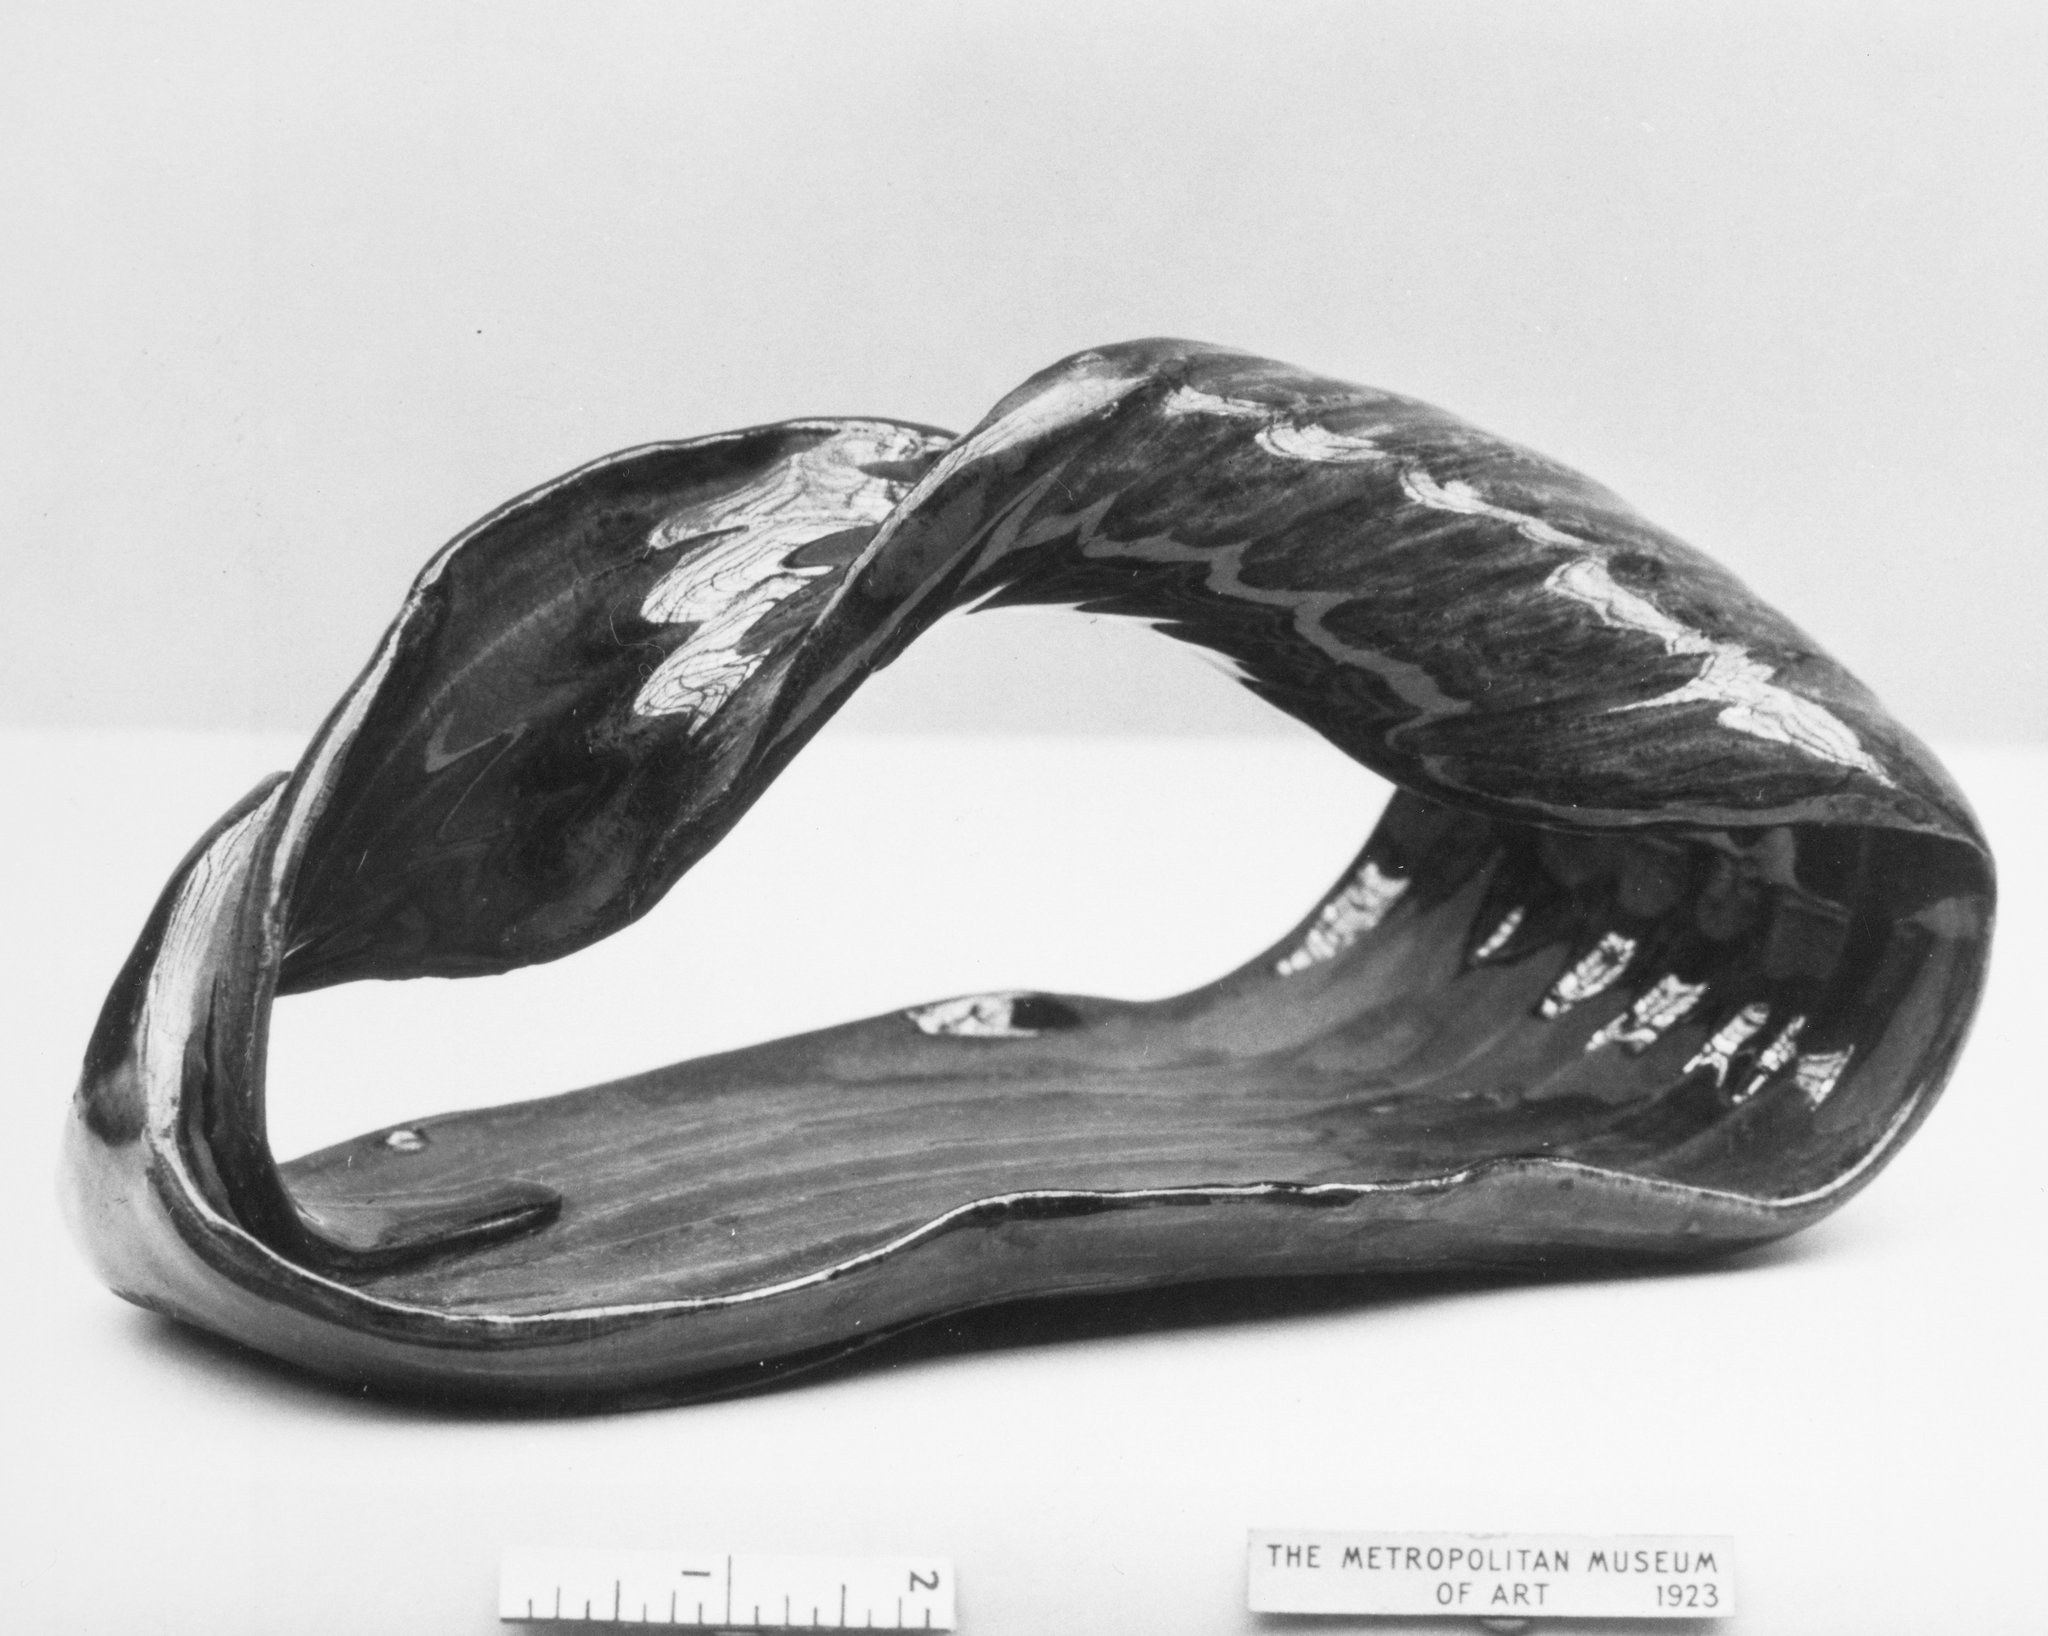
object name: cake dish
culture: japanese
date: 1865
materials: faience, glaze